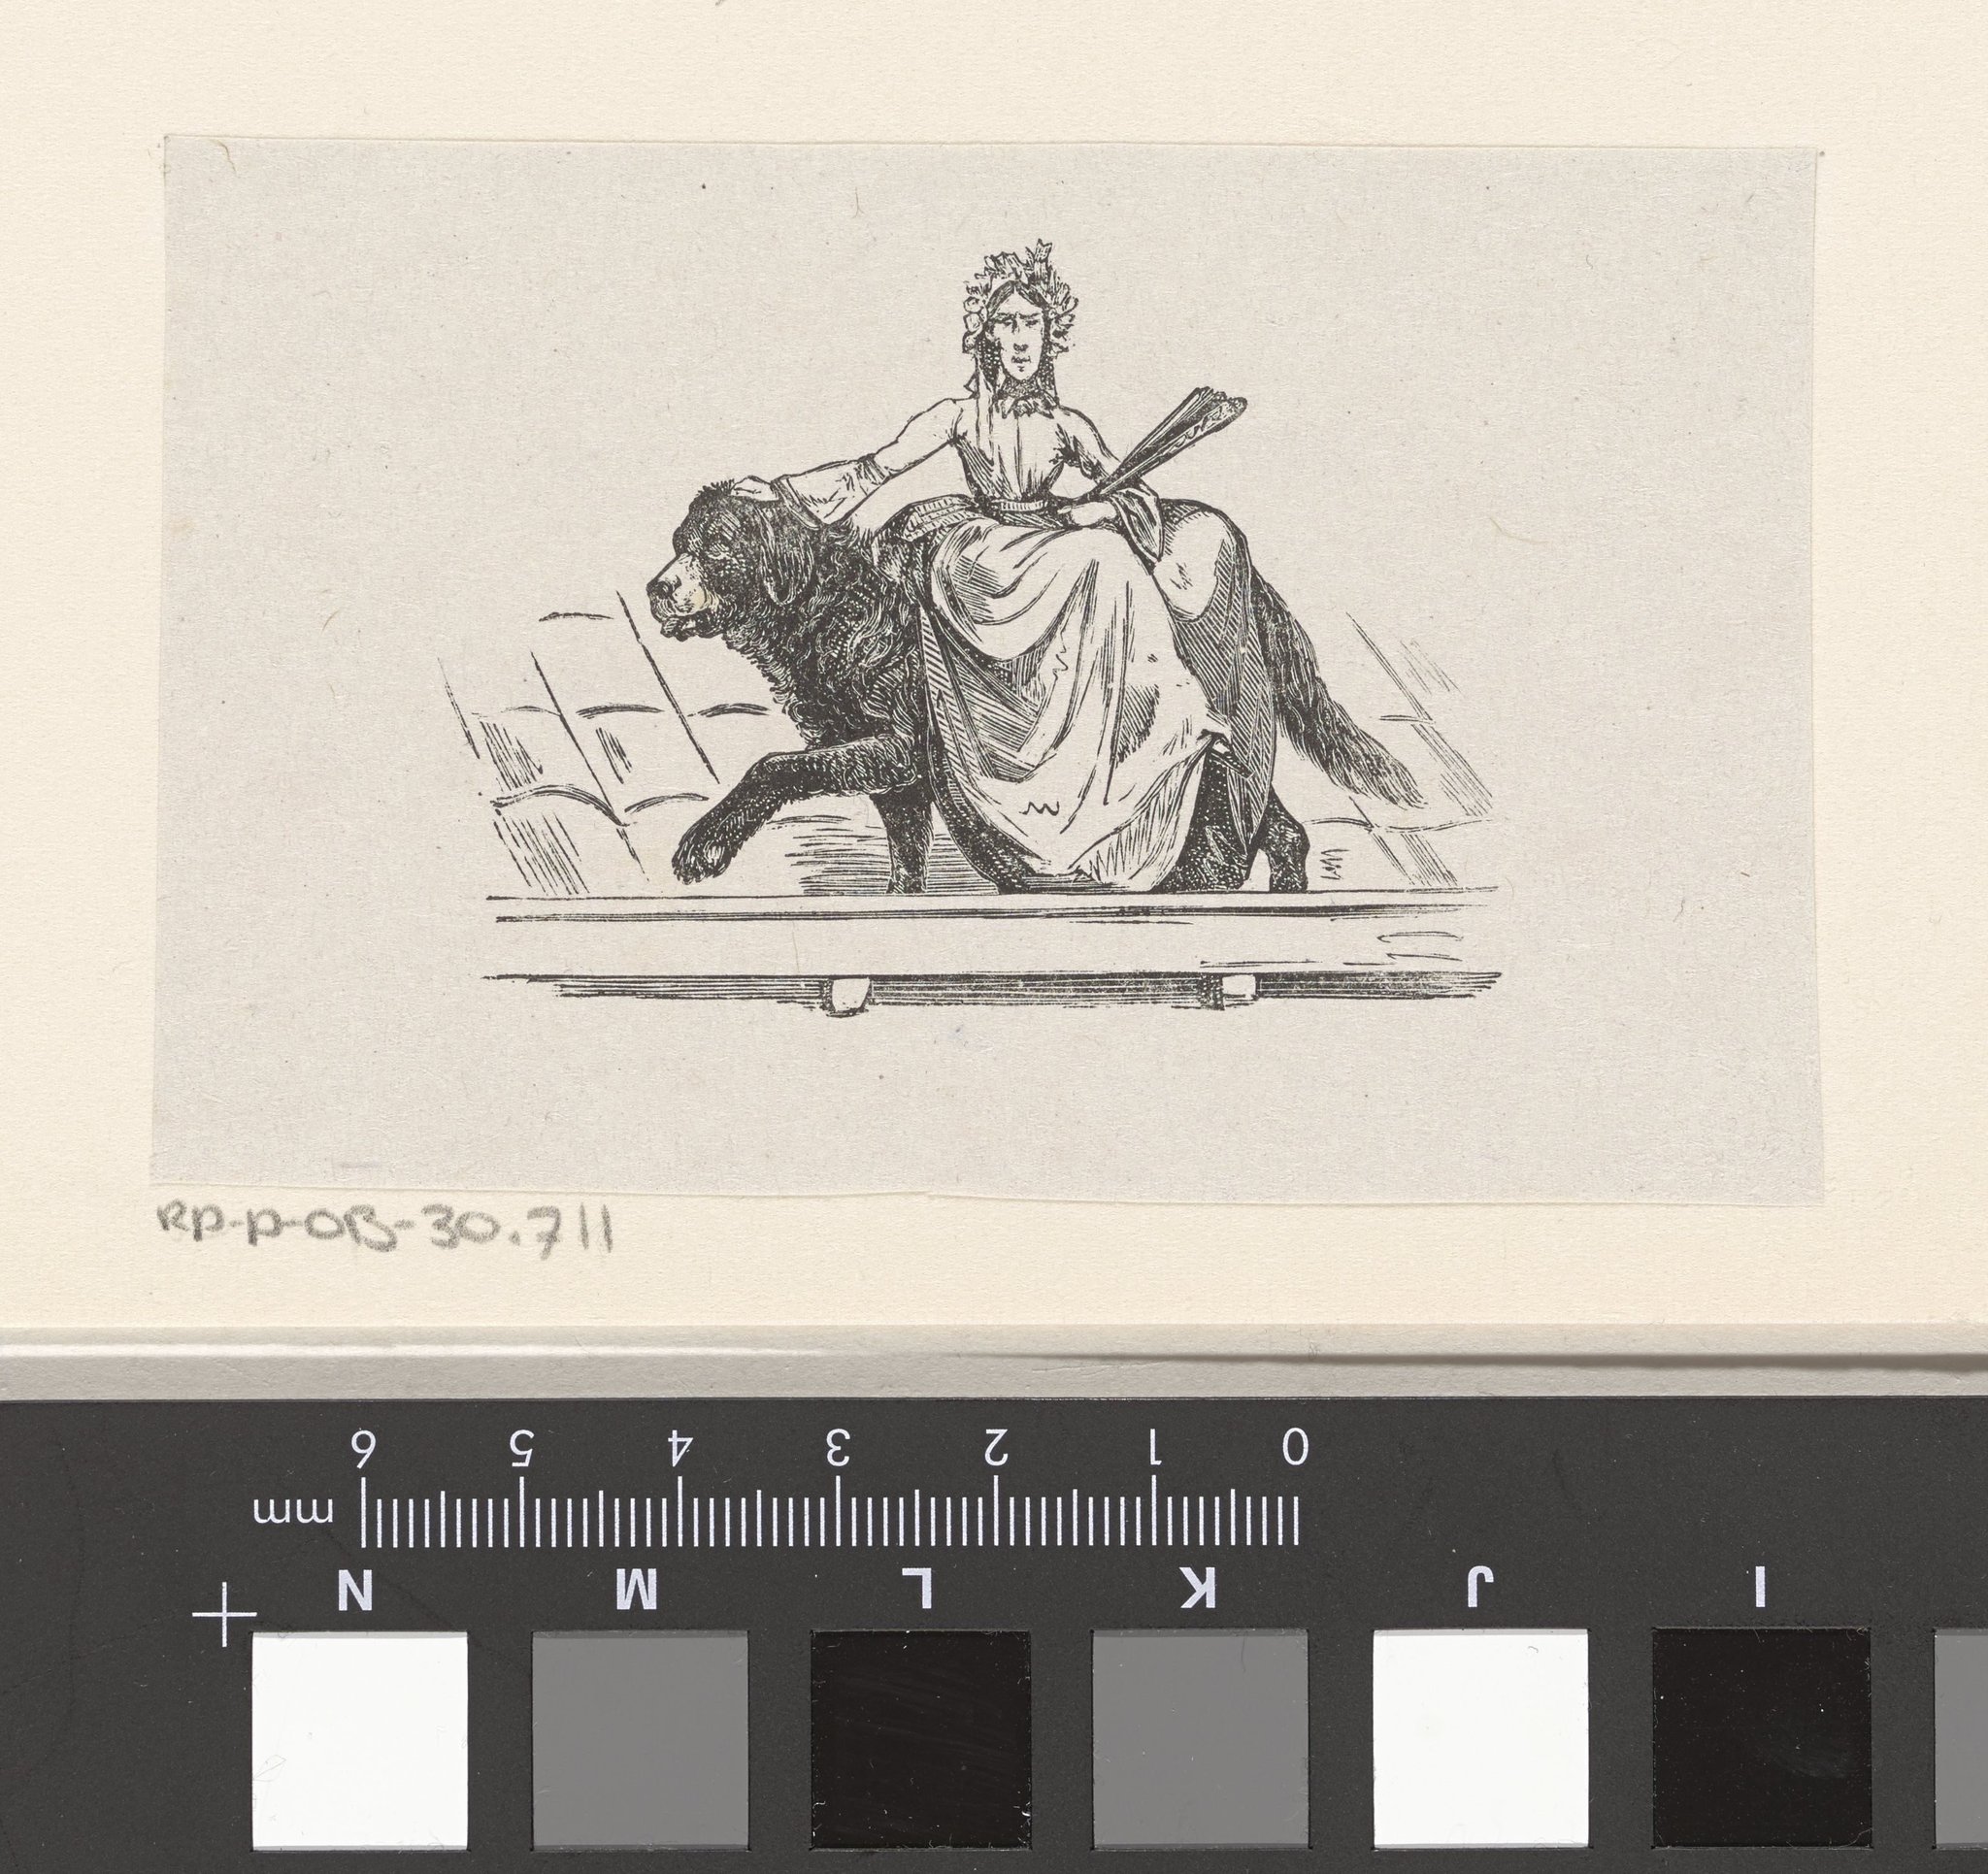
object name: print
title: Vrouw met een waaier zittend op de rug van een hond op een daklijst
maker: isaac weissenbruch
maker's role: print maker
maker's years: 1826-1912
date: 1836-1912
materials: paper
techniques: engraving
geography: netherlands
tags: roof (of house or building), fan, adult woman (+ sitting), dog